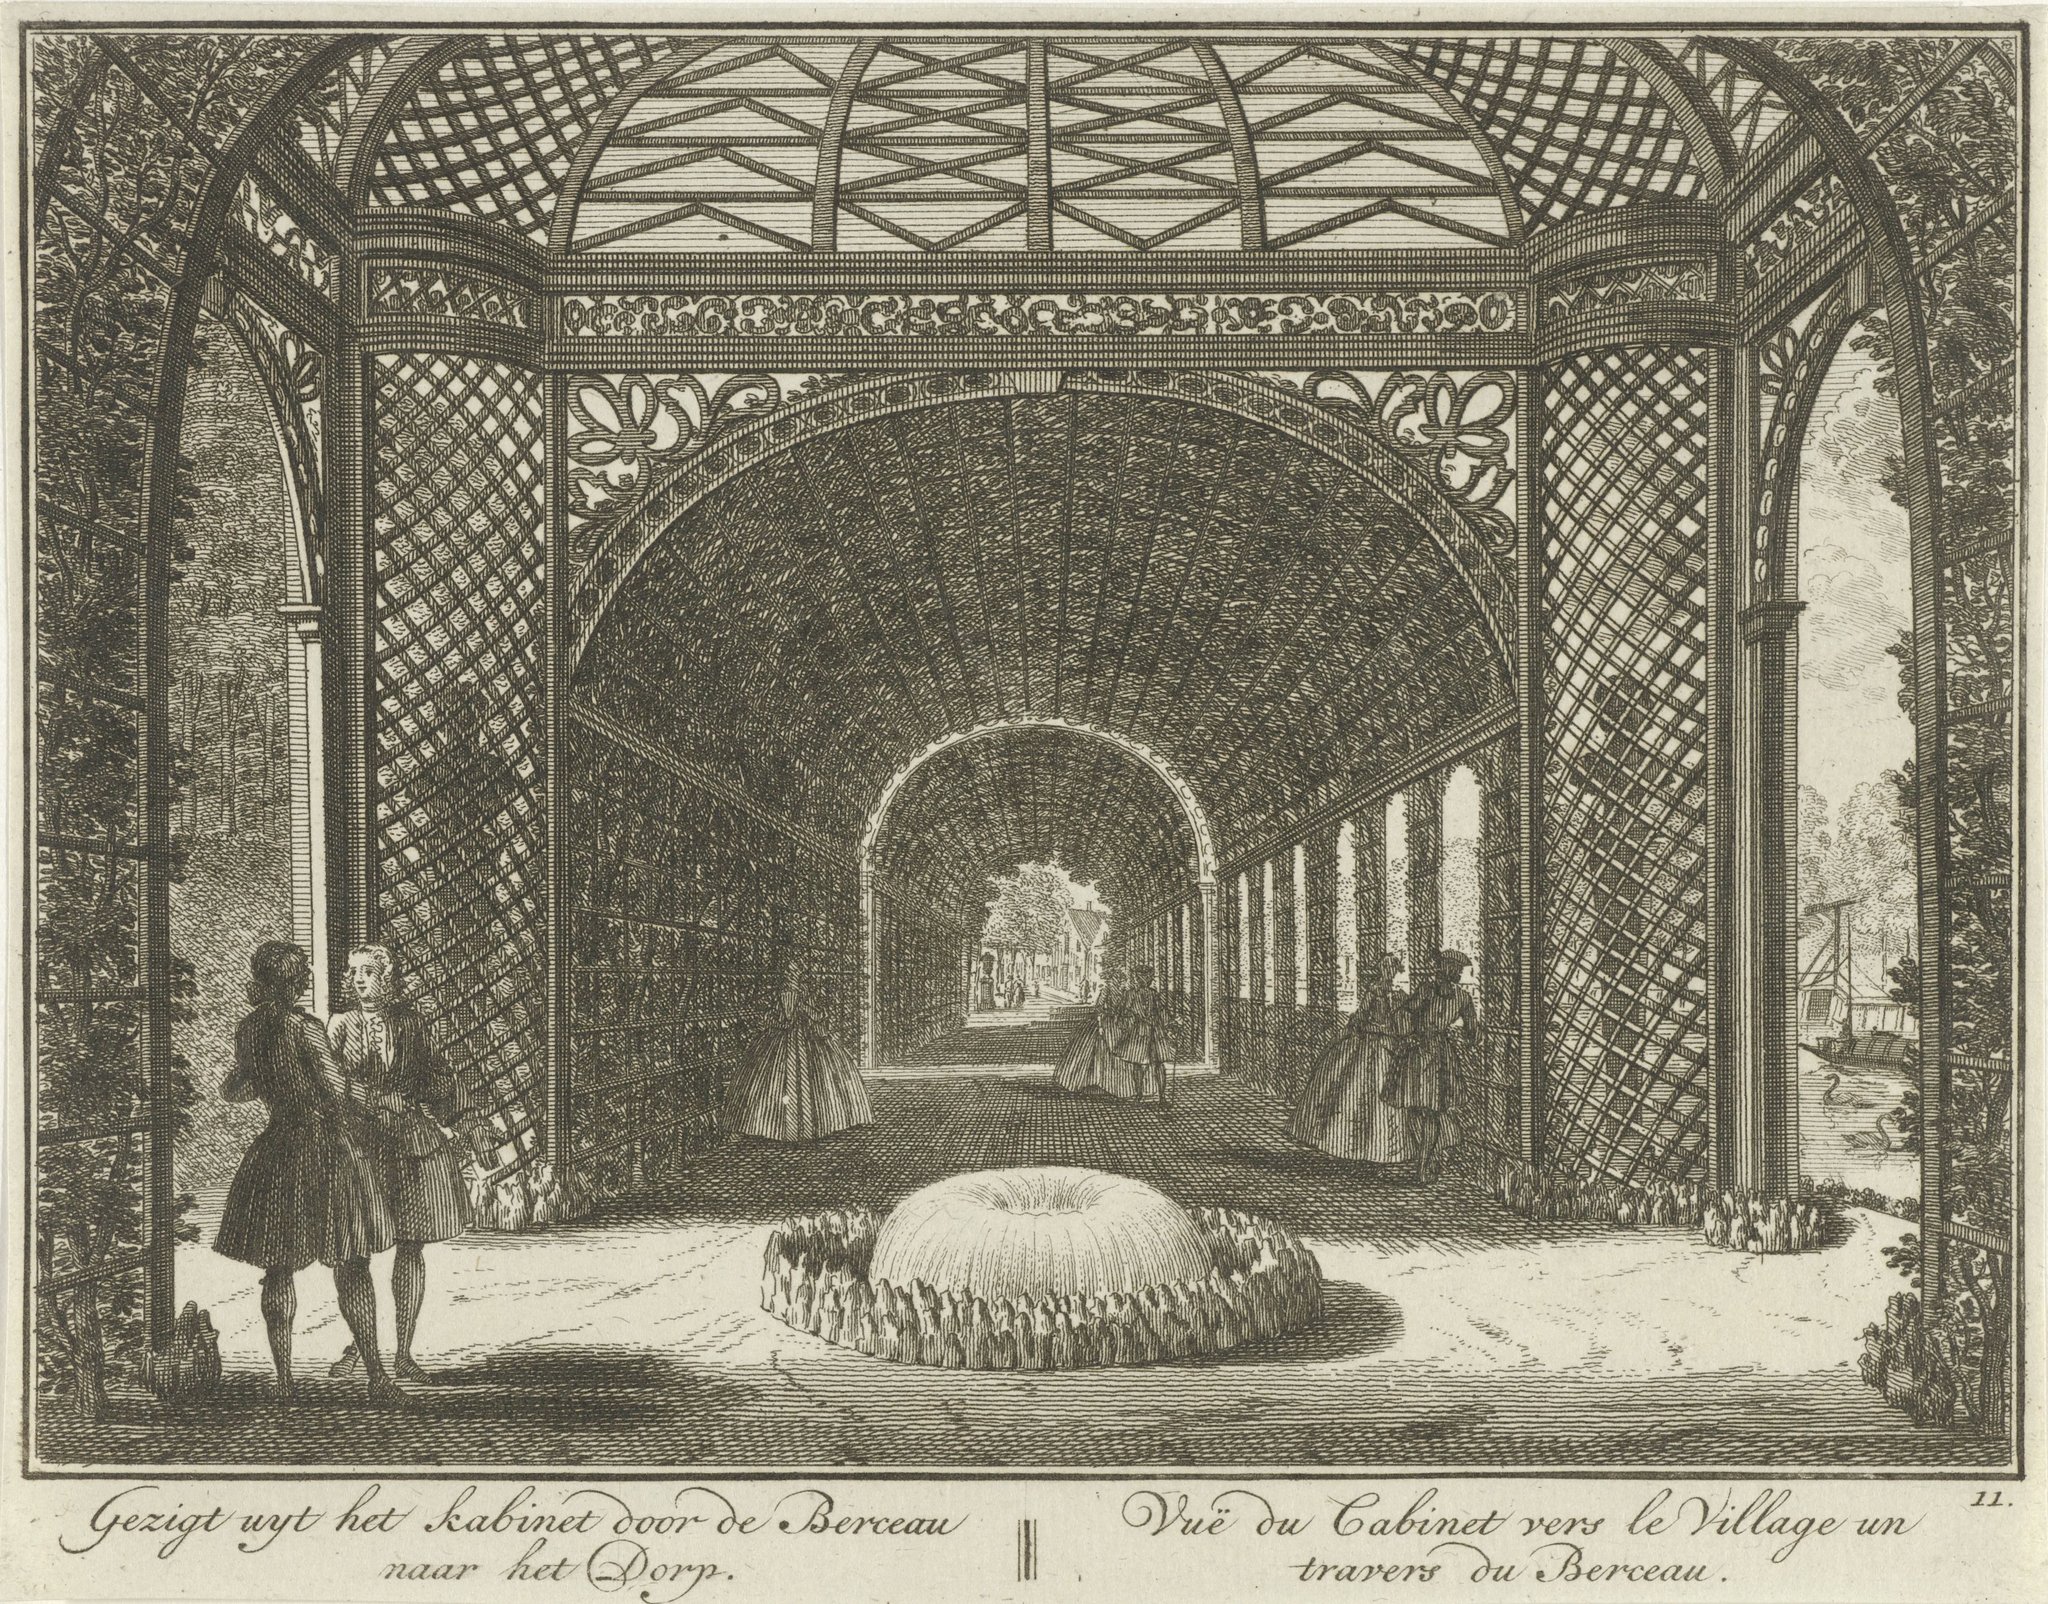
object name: print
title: Het Oud Adelyk huys en Ridderhofstad Ter Meer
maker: hendrik de leth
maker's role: draughtsman, print maker, publisher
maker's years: 1703-1766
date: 1740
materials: paper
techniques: etching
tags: french or architectonic garden; formal garden, country-house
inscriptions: collector's mark: Lugt 2228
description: Doorkijk door de berceau in de Franse tuin van Huis ter Meer met diverse wandelende en converserende figuren. De prent maakt deel uit van een serie met 26 gezichten op Huis ter Meer en het bijbehorende landgoed te Maarssen.